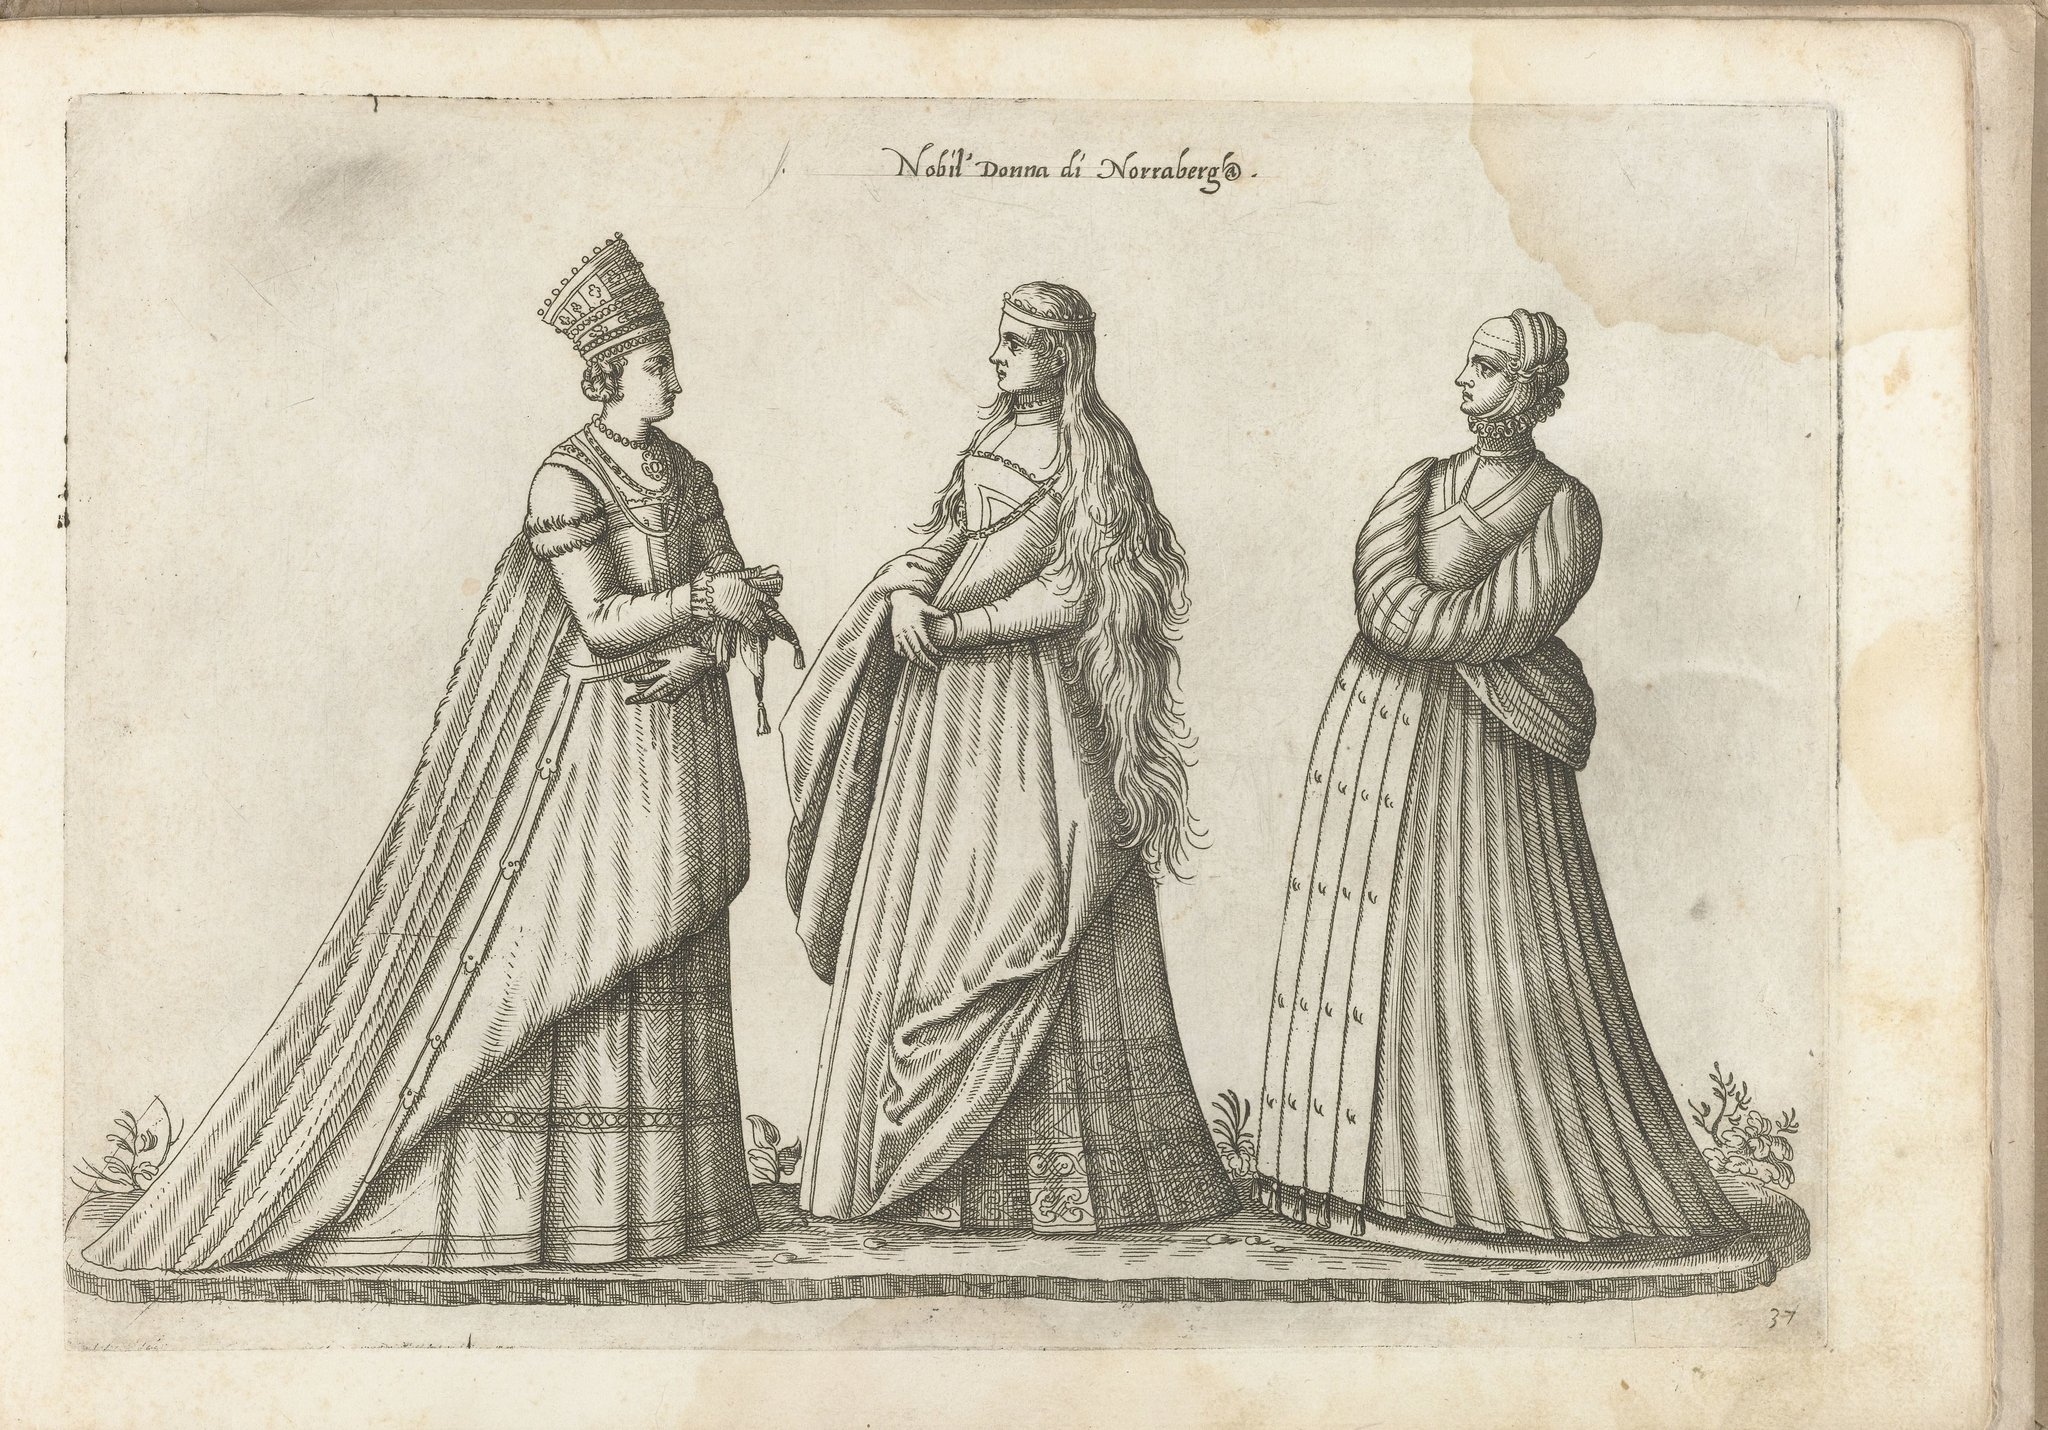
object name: costume print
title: Drie vrouwen, gekleed volgens de mode in Neurenberg van ca. 1580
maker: bartolomeo grassi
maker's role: publisher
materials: paper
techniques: engraving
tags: bride and groom in wedding-dress, europeans: germans (+ costume)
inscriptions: number: ‘36’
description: Prent uit album 'Dei veri ritratti degl'habiti di tvtte le parti del mondo intagliati in rame per opra di Bartolomeo Grassi', 1585.